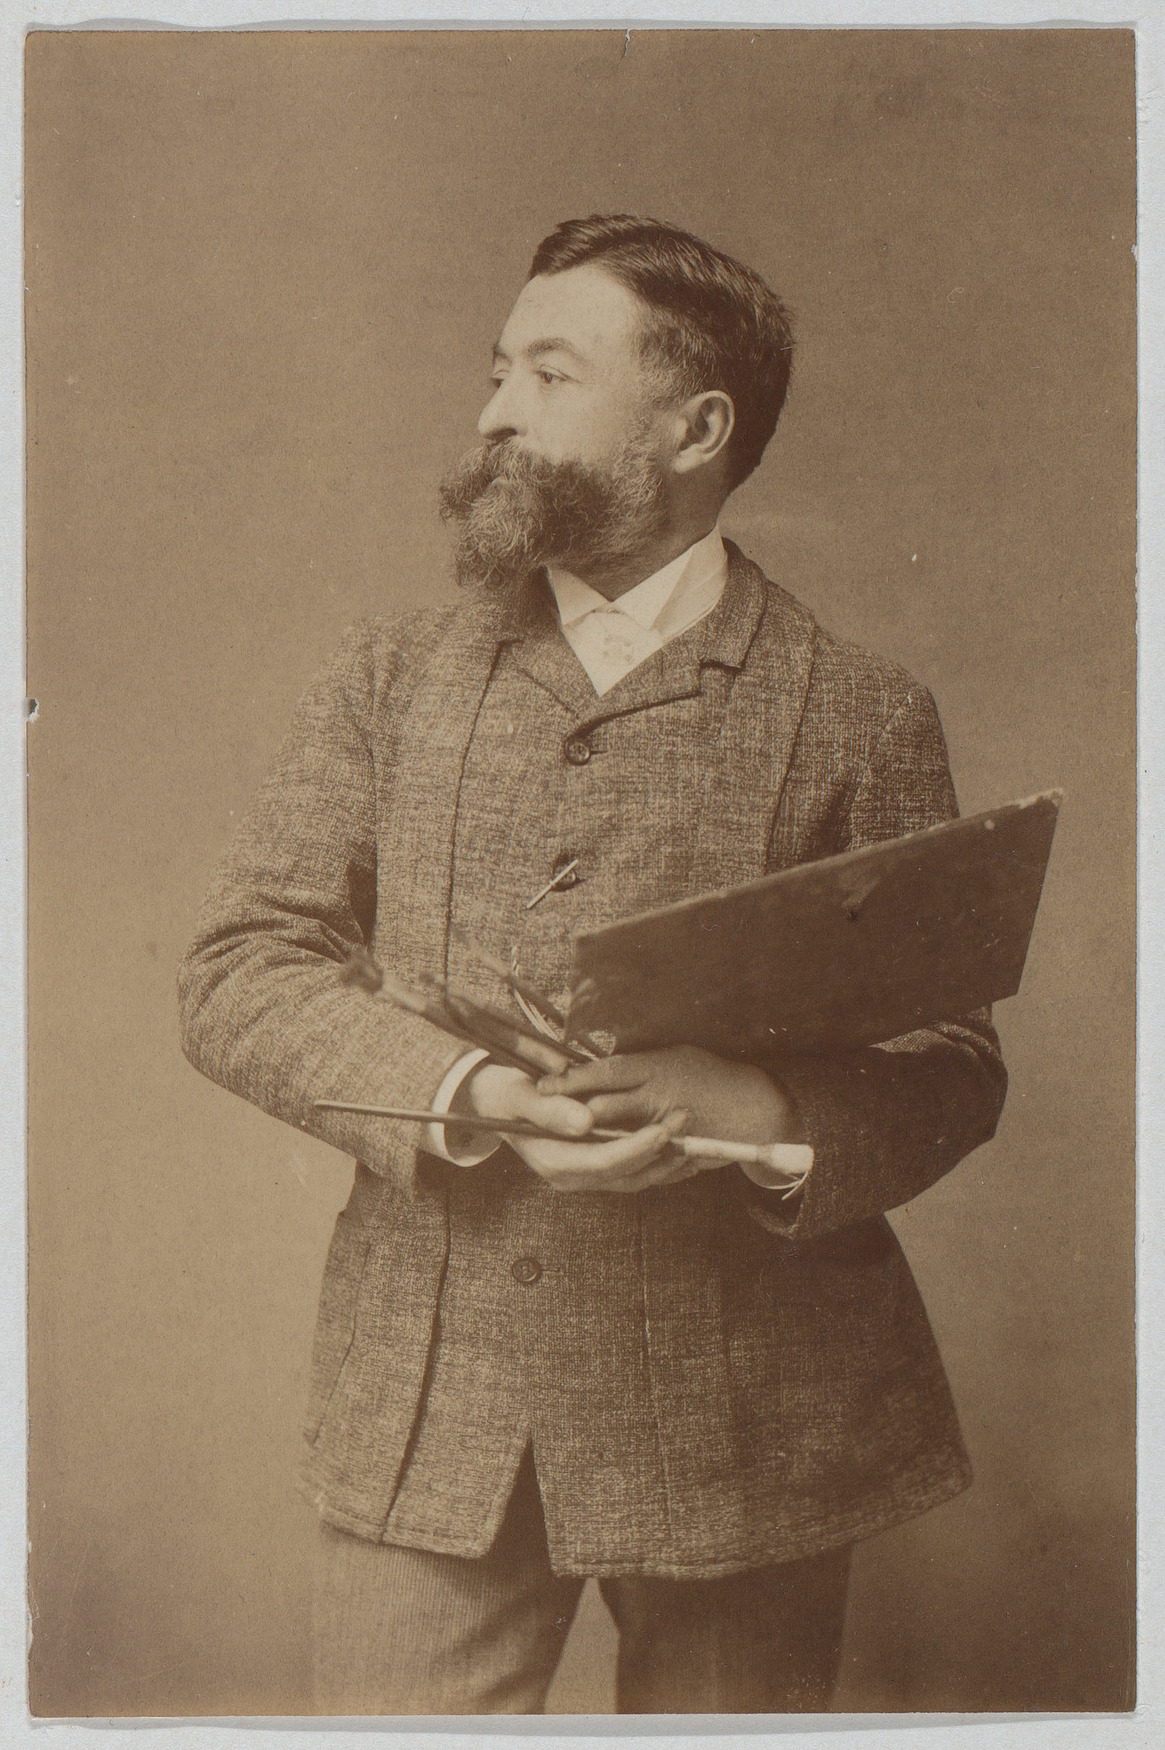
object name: print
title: Three-quarter Length Portrait of Thomas Nast Holding Palette and Brush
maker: thomas nast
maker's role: artist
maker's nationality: american, born germany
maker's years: 1840-1902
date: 1888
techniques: photography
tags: men,portraits,palettes,brushes